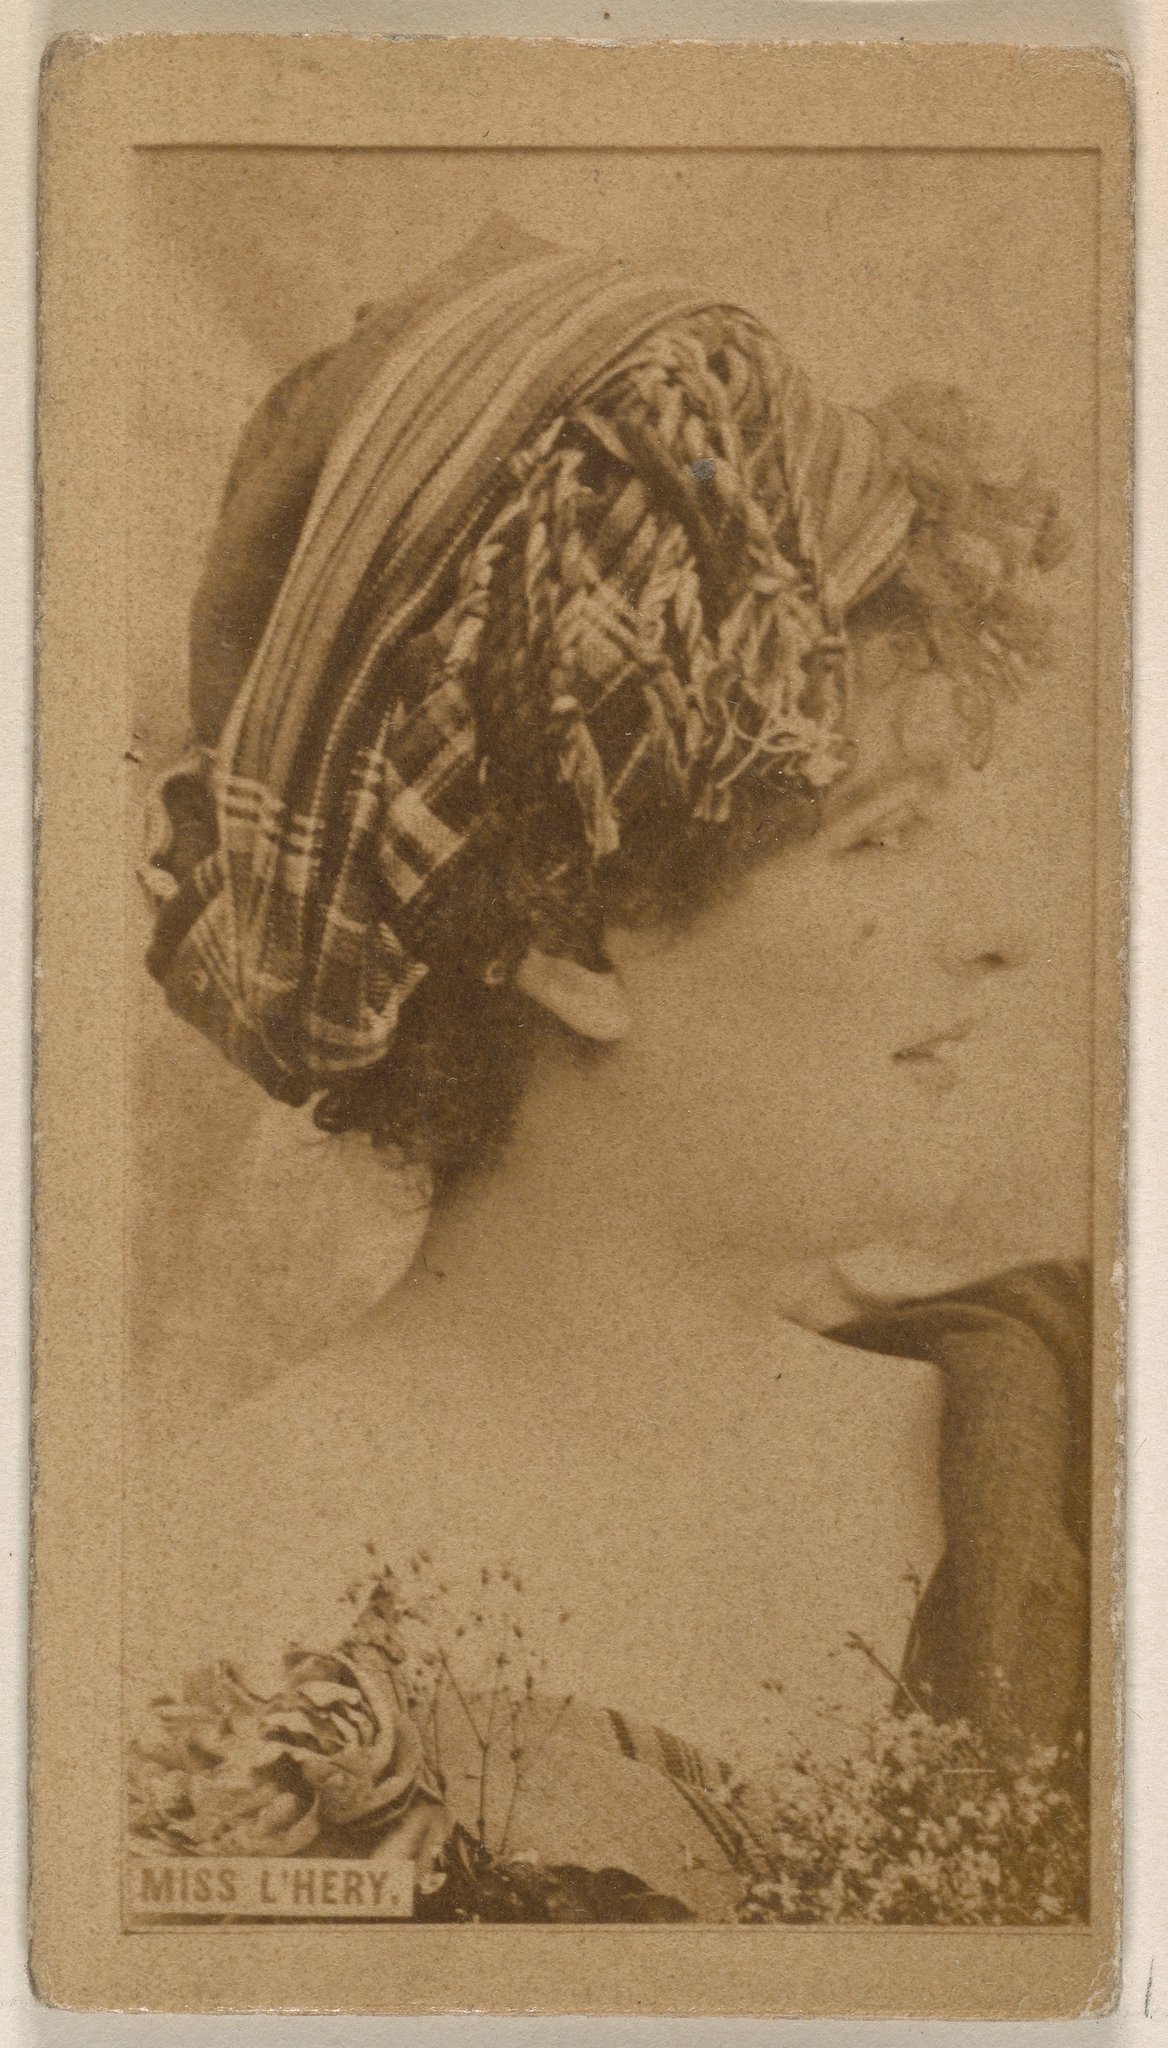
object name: photograph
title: Miss L'Hery, from the Actresses series (N245) issued by Kinney Brothers to promote Sweet Caporal Cigarettes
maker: kinney brothers tobacco company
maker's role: publisher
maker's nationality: american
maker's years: 1869-2011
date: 1890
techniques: albumen silver print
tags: women,actresses